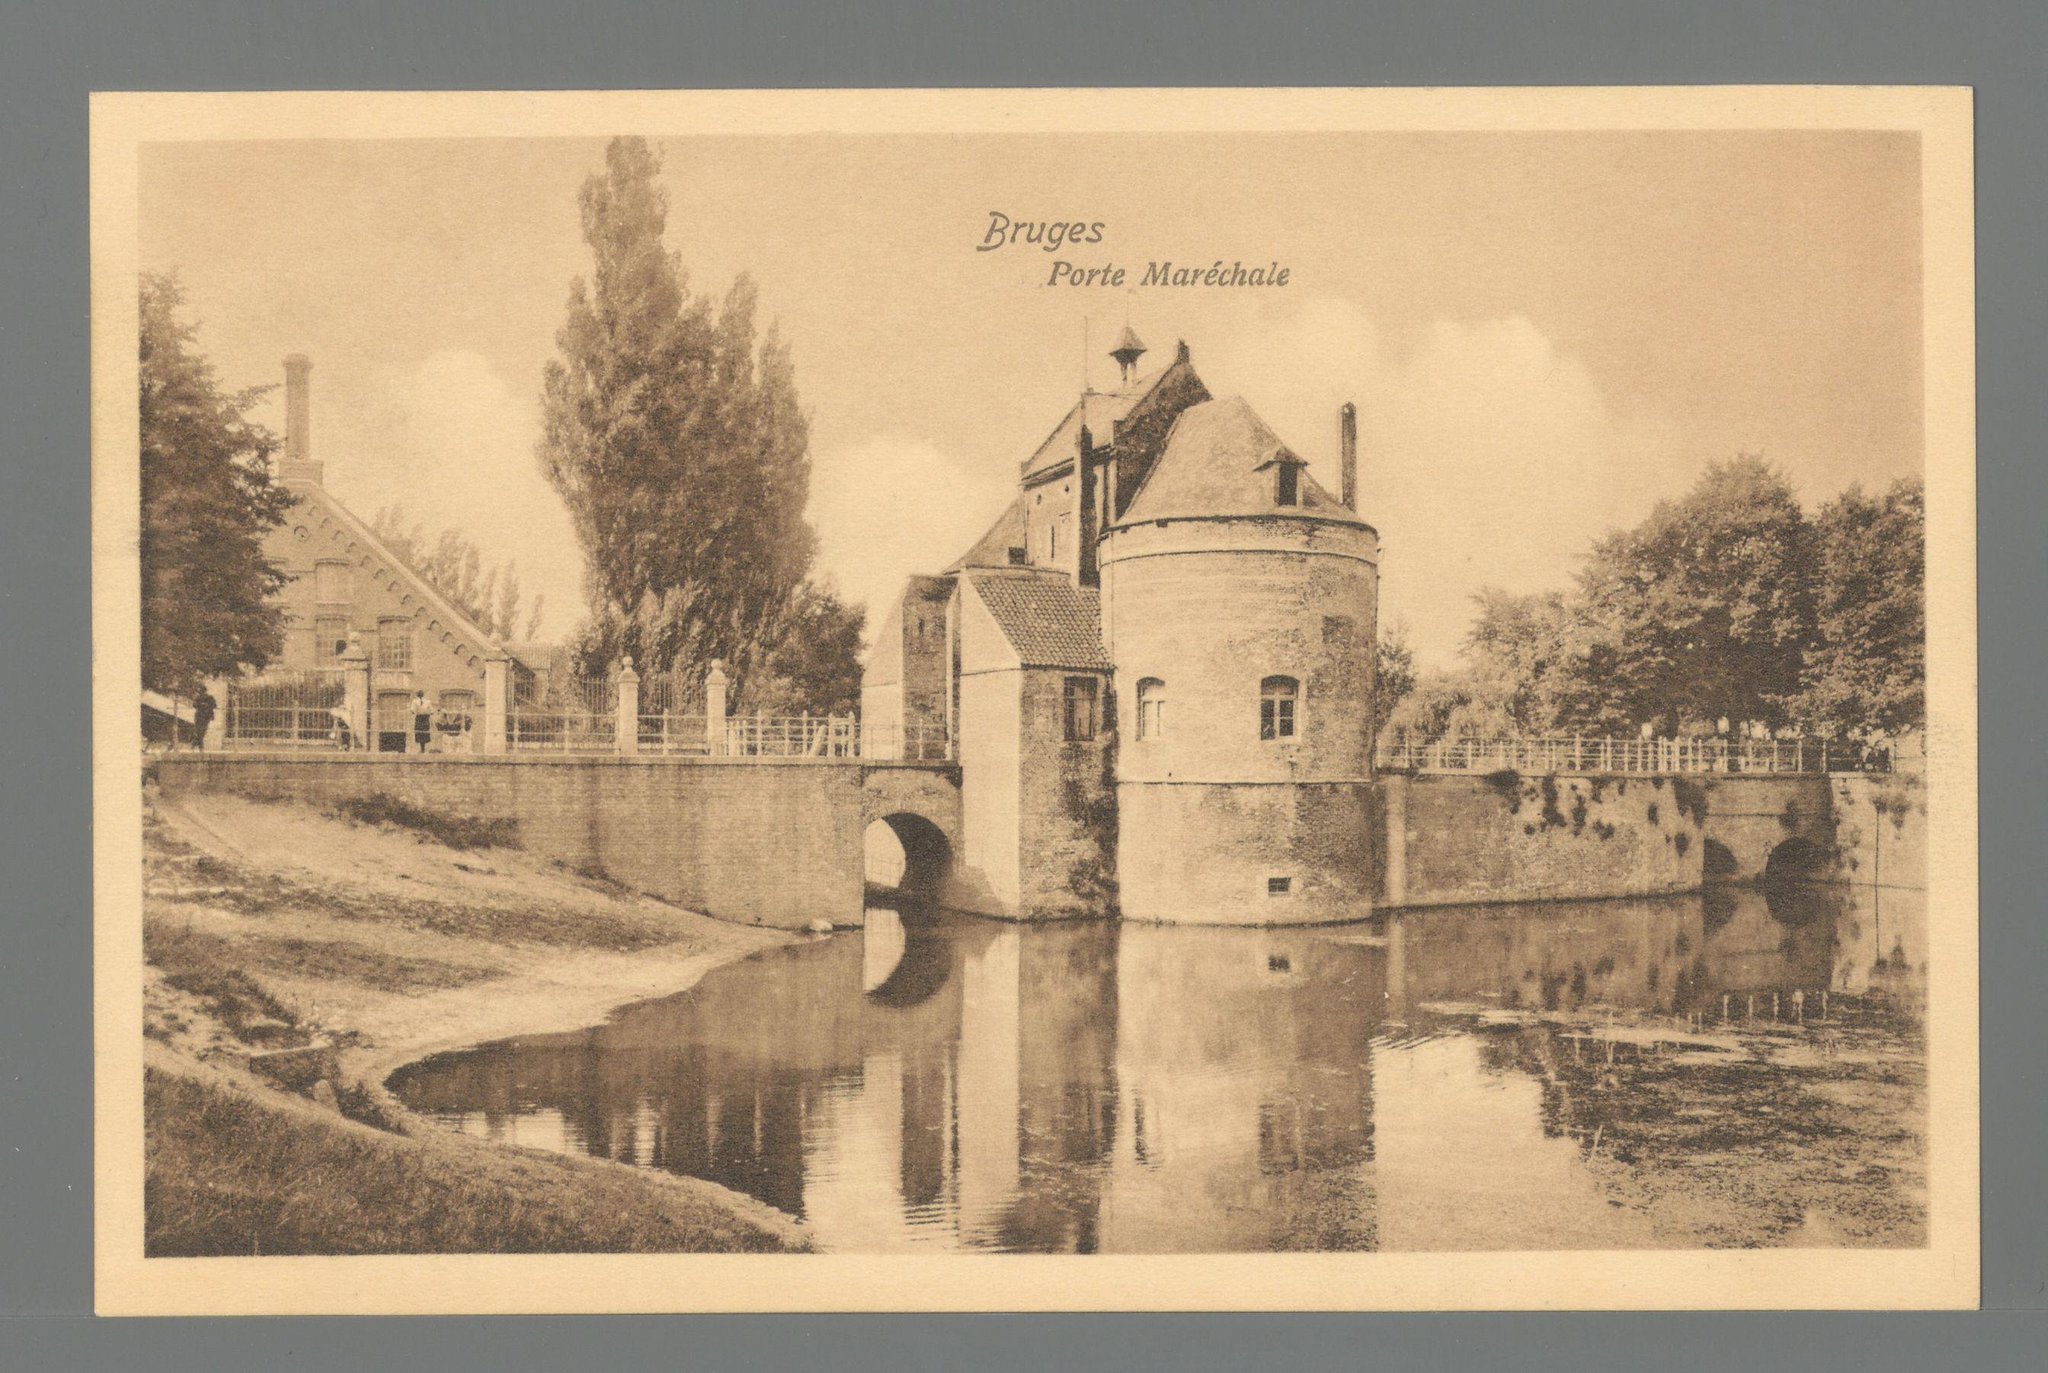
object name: ansichtkaart, prentbriefkaart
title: Bruges. Porte Maréchale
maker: Anonymous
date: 1906-1930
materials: cardboard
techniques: photograph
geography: bruges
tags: water course, city-gate, bruges